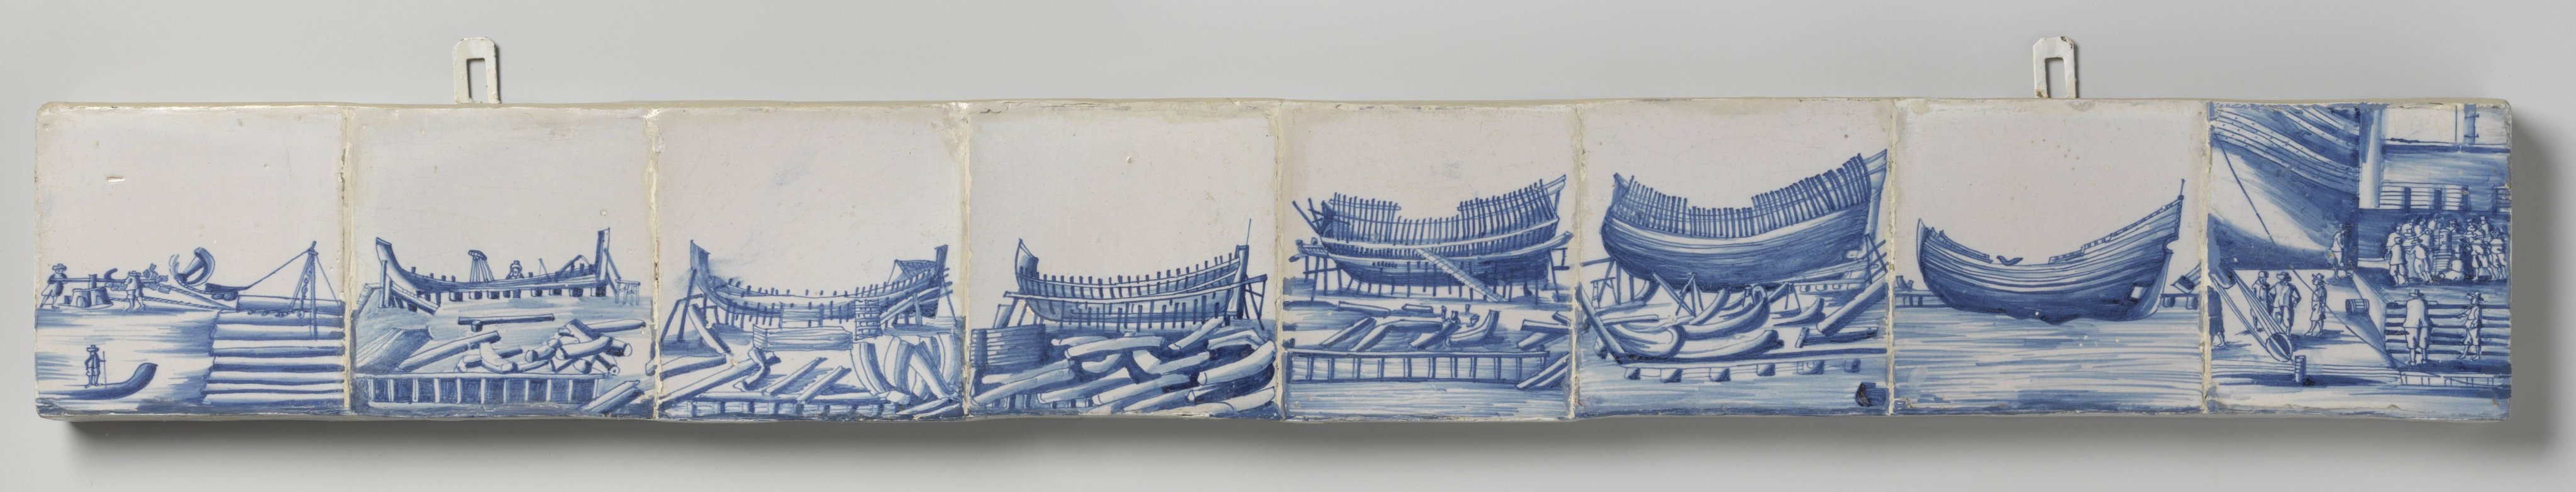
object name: tile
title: Veld van acht tegels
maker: Anonymous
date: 1600-1650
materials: earthenware, glaze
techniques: maiolica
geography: netherlands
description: Veld van acht tegels (1 x 8) elk met een blauw geschilderd schip in aanbouw.